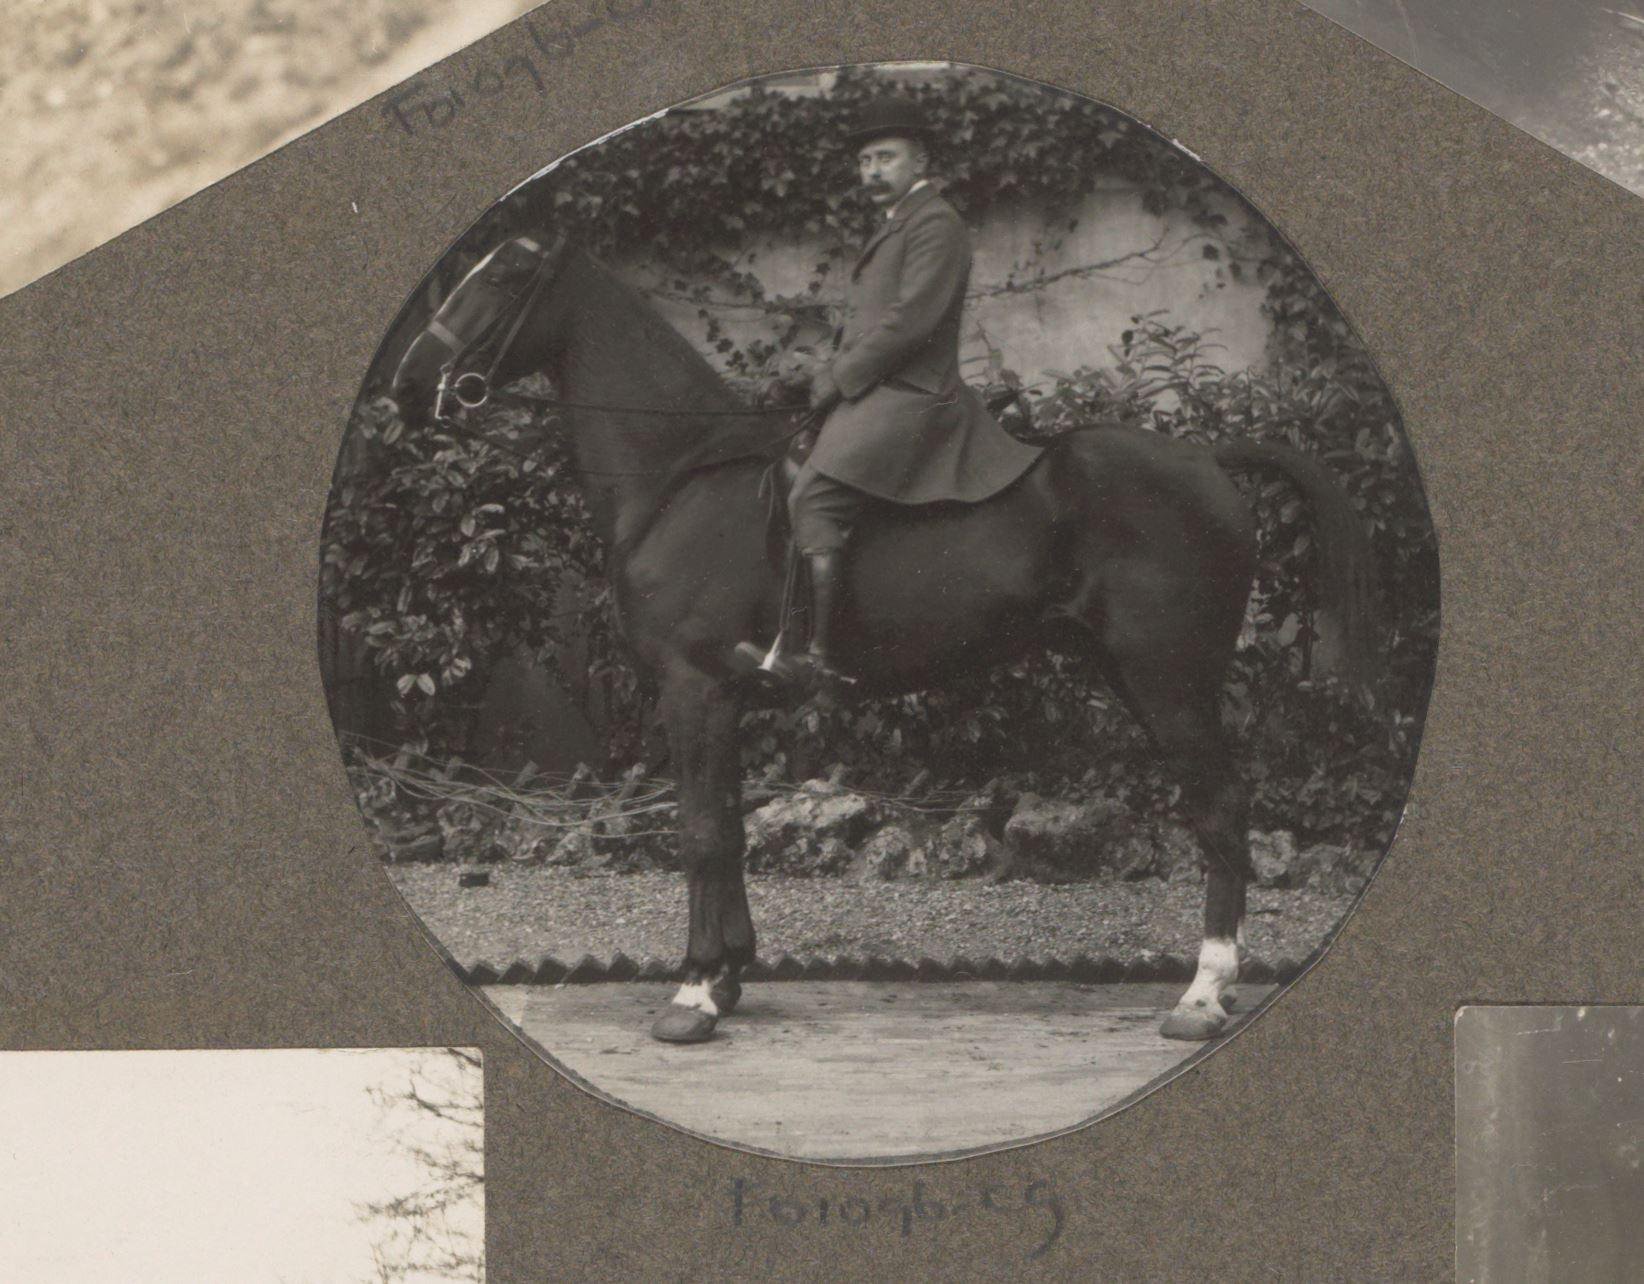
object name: photograph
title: Ruitertafereel op Koninklijke Houtvesterij Het Loo: man te paard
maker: Anonymous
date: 1900-1925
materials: photographic support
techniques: gelatin silver print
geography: het loo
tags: riding a horse, ass, or mule; rider, horseman, hunting, chase, hunting-ground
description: Onderdeel van Fotoalbum van de heer Brams, opperhoutvester van koningin Wilhelmina op Koninklijke Houtvesterij Het Loo.